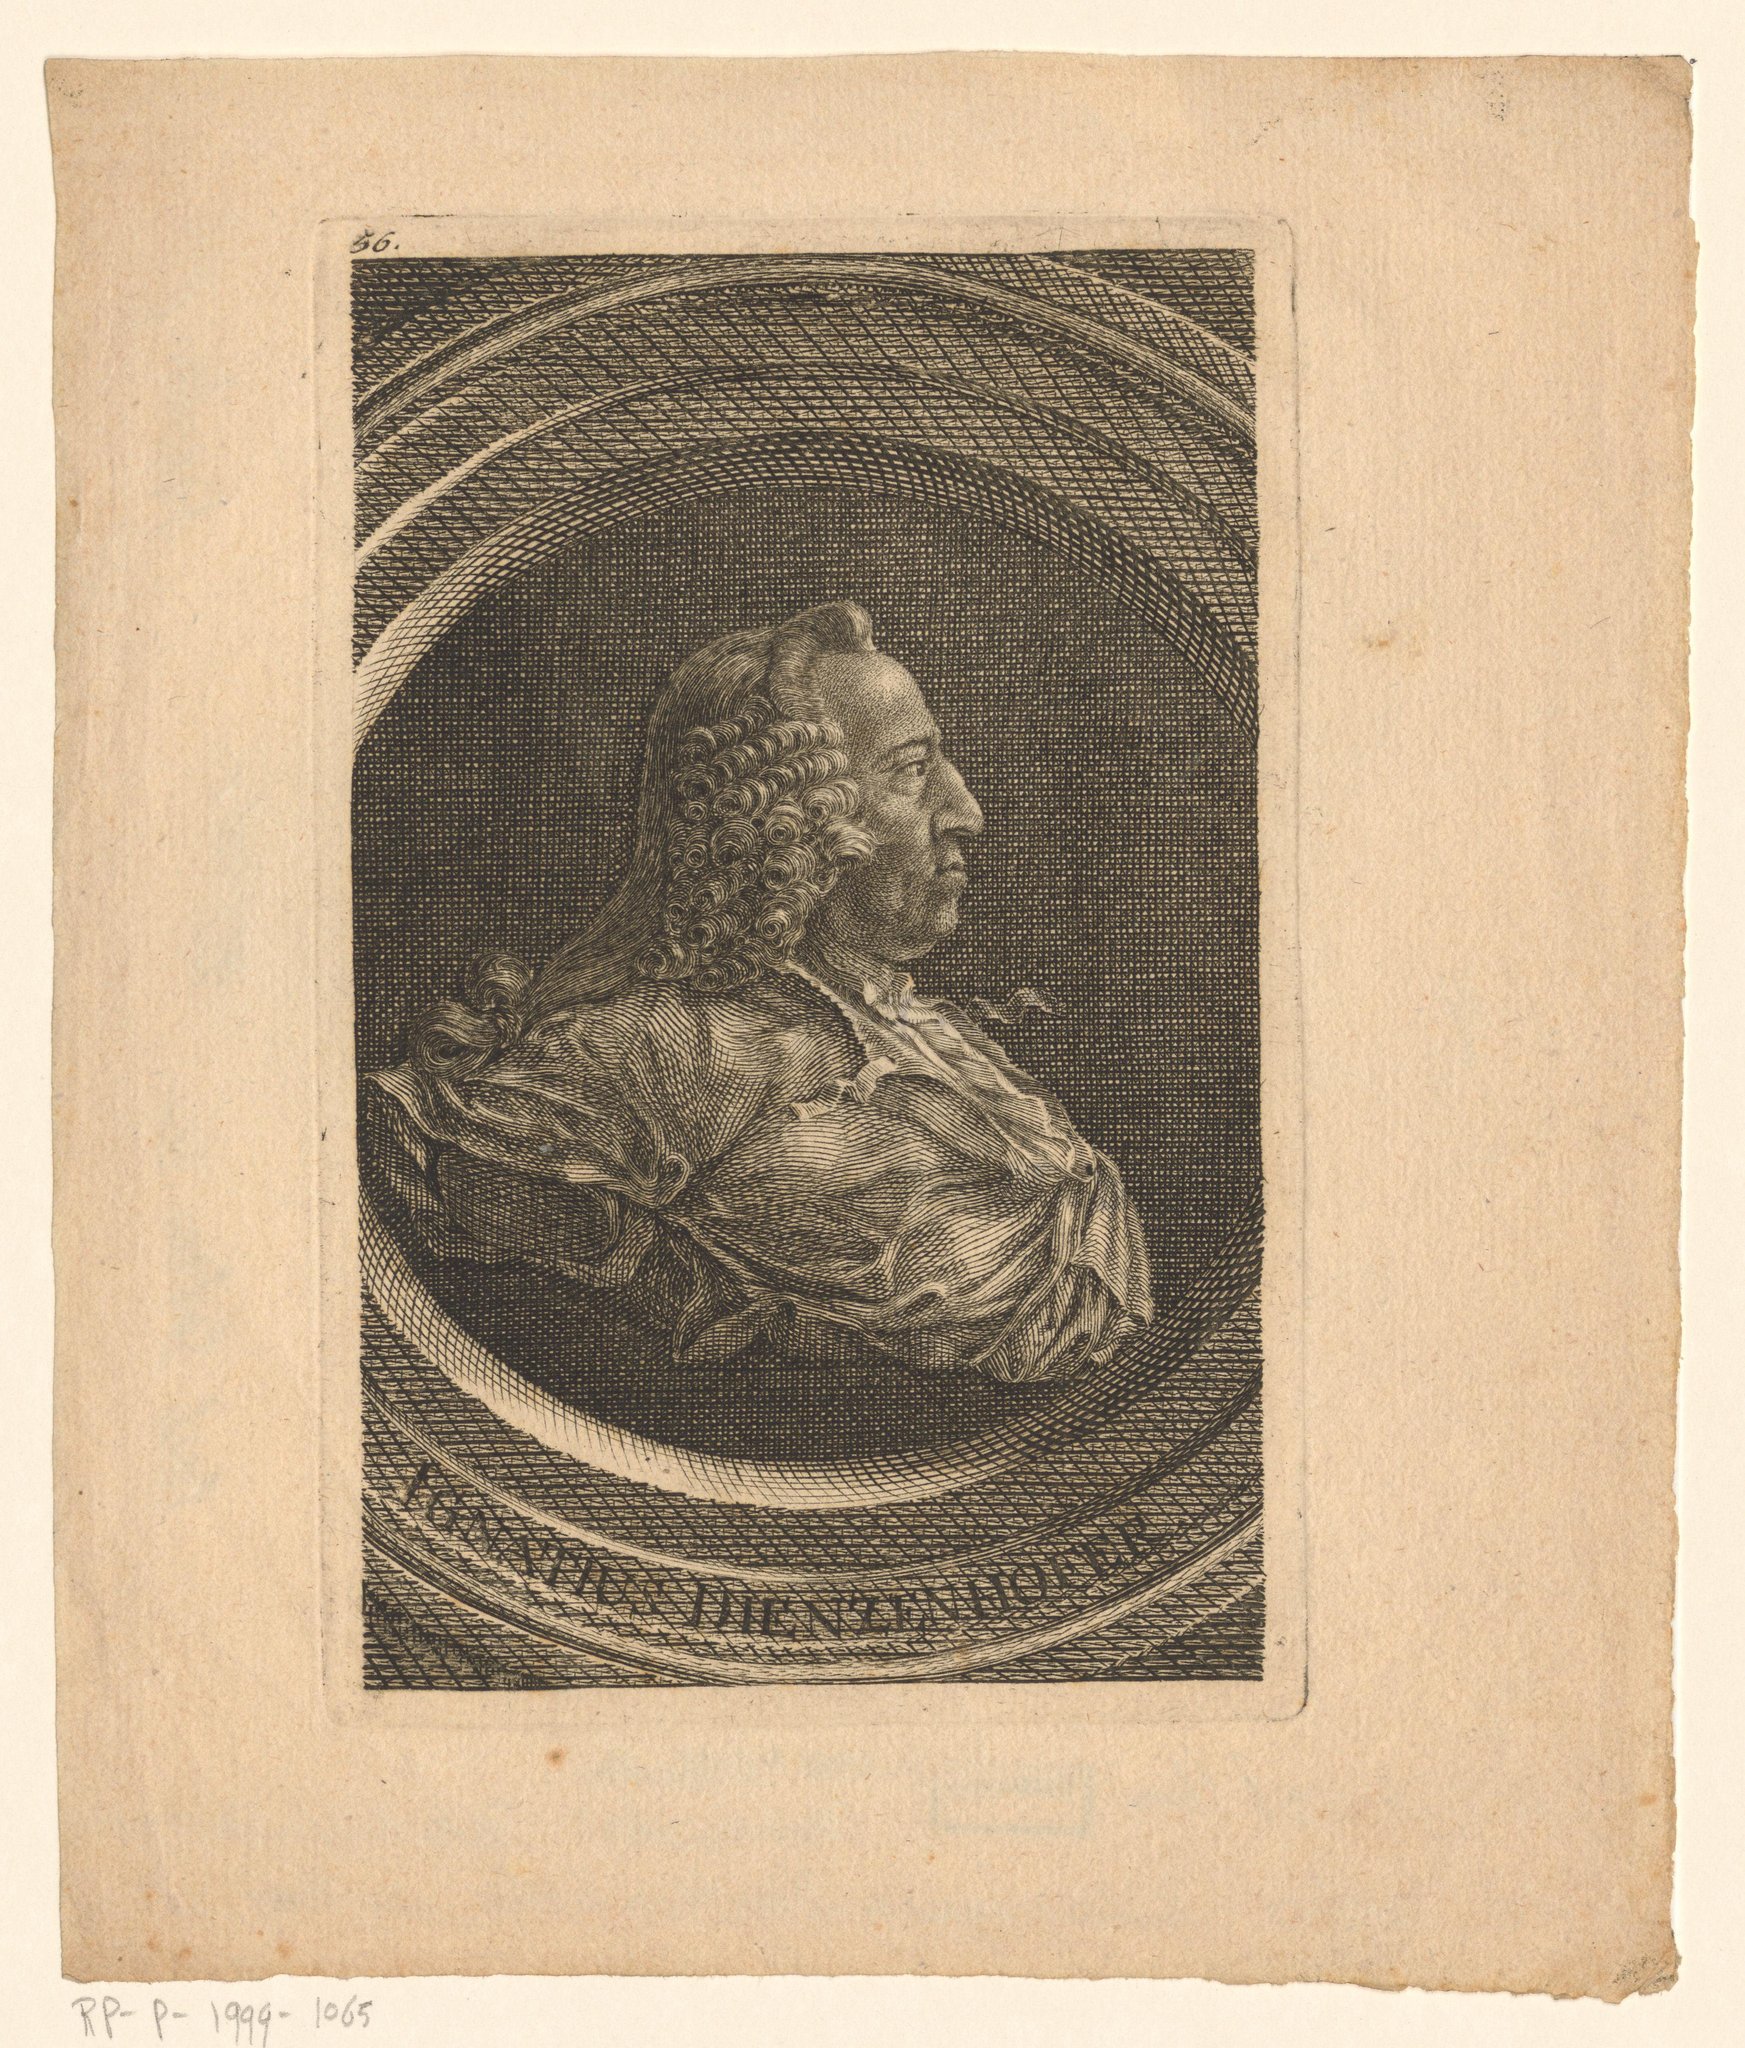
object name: print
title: Portret van Kilian Ignaz Dientzenhofer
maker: carl salzer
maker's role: print maker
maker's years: 1740-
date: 1772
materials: paper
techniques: engraving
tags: historical persons, portrait, self-portrait of architect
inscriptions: stamp: ‘lfd. No 56’, stamp: ‘Zg.B. 5. p. 66’, collector's mark: Lugt 2760, collector's mark: Lugt 2888, collector's mark: Lugt 2481a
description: Prent waarschijnlijk uit: Balzer, Johann. 87 Abbildungen Böhmischer und Mährischer Gelehrten und Künstler. Praag: s.n., [1772], prent 56 (alle prenten na de tekst). Andere staat van prent gebruikt in: Born, Ignaz Baron von. Effigies virorum eduditorum atque artificum Bohemiae et Moraviae (...). Praag: Wolfgangg Gerle, 1773-1775, dl. 2, p. 152.